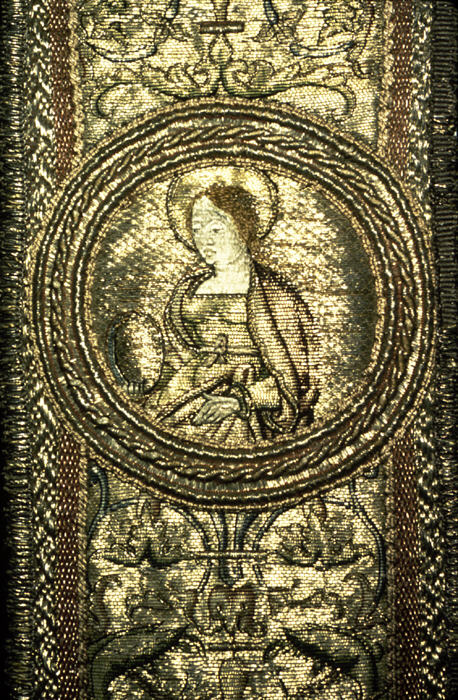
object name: orphrey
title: Orphrey (one of a pair)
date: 1501-1600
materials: metal thread, silk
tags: women